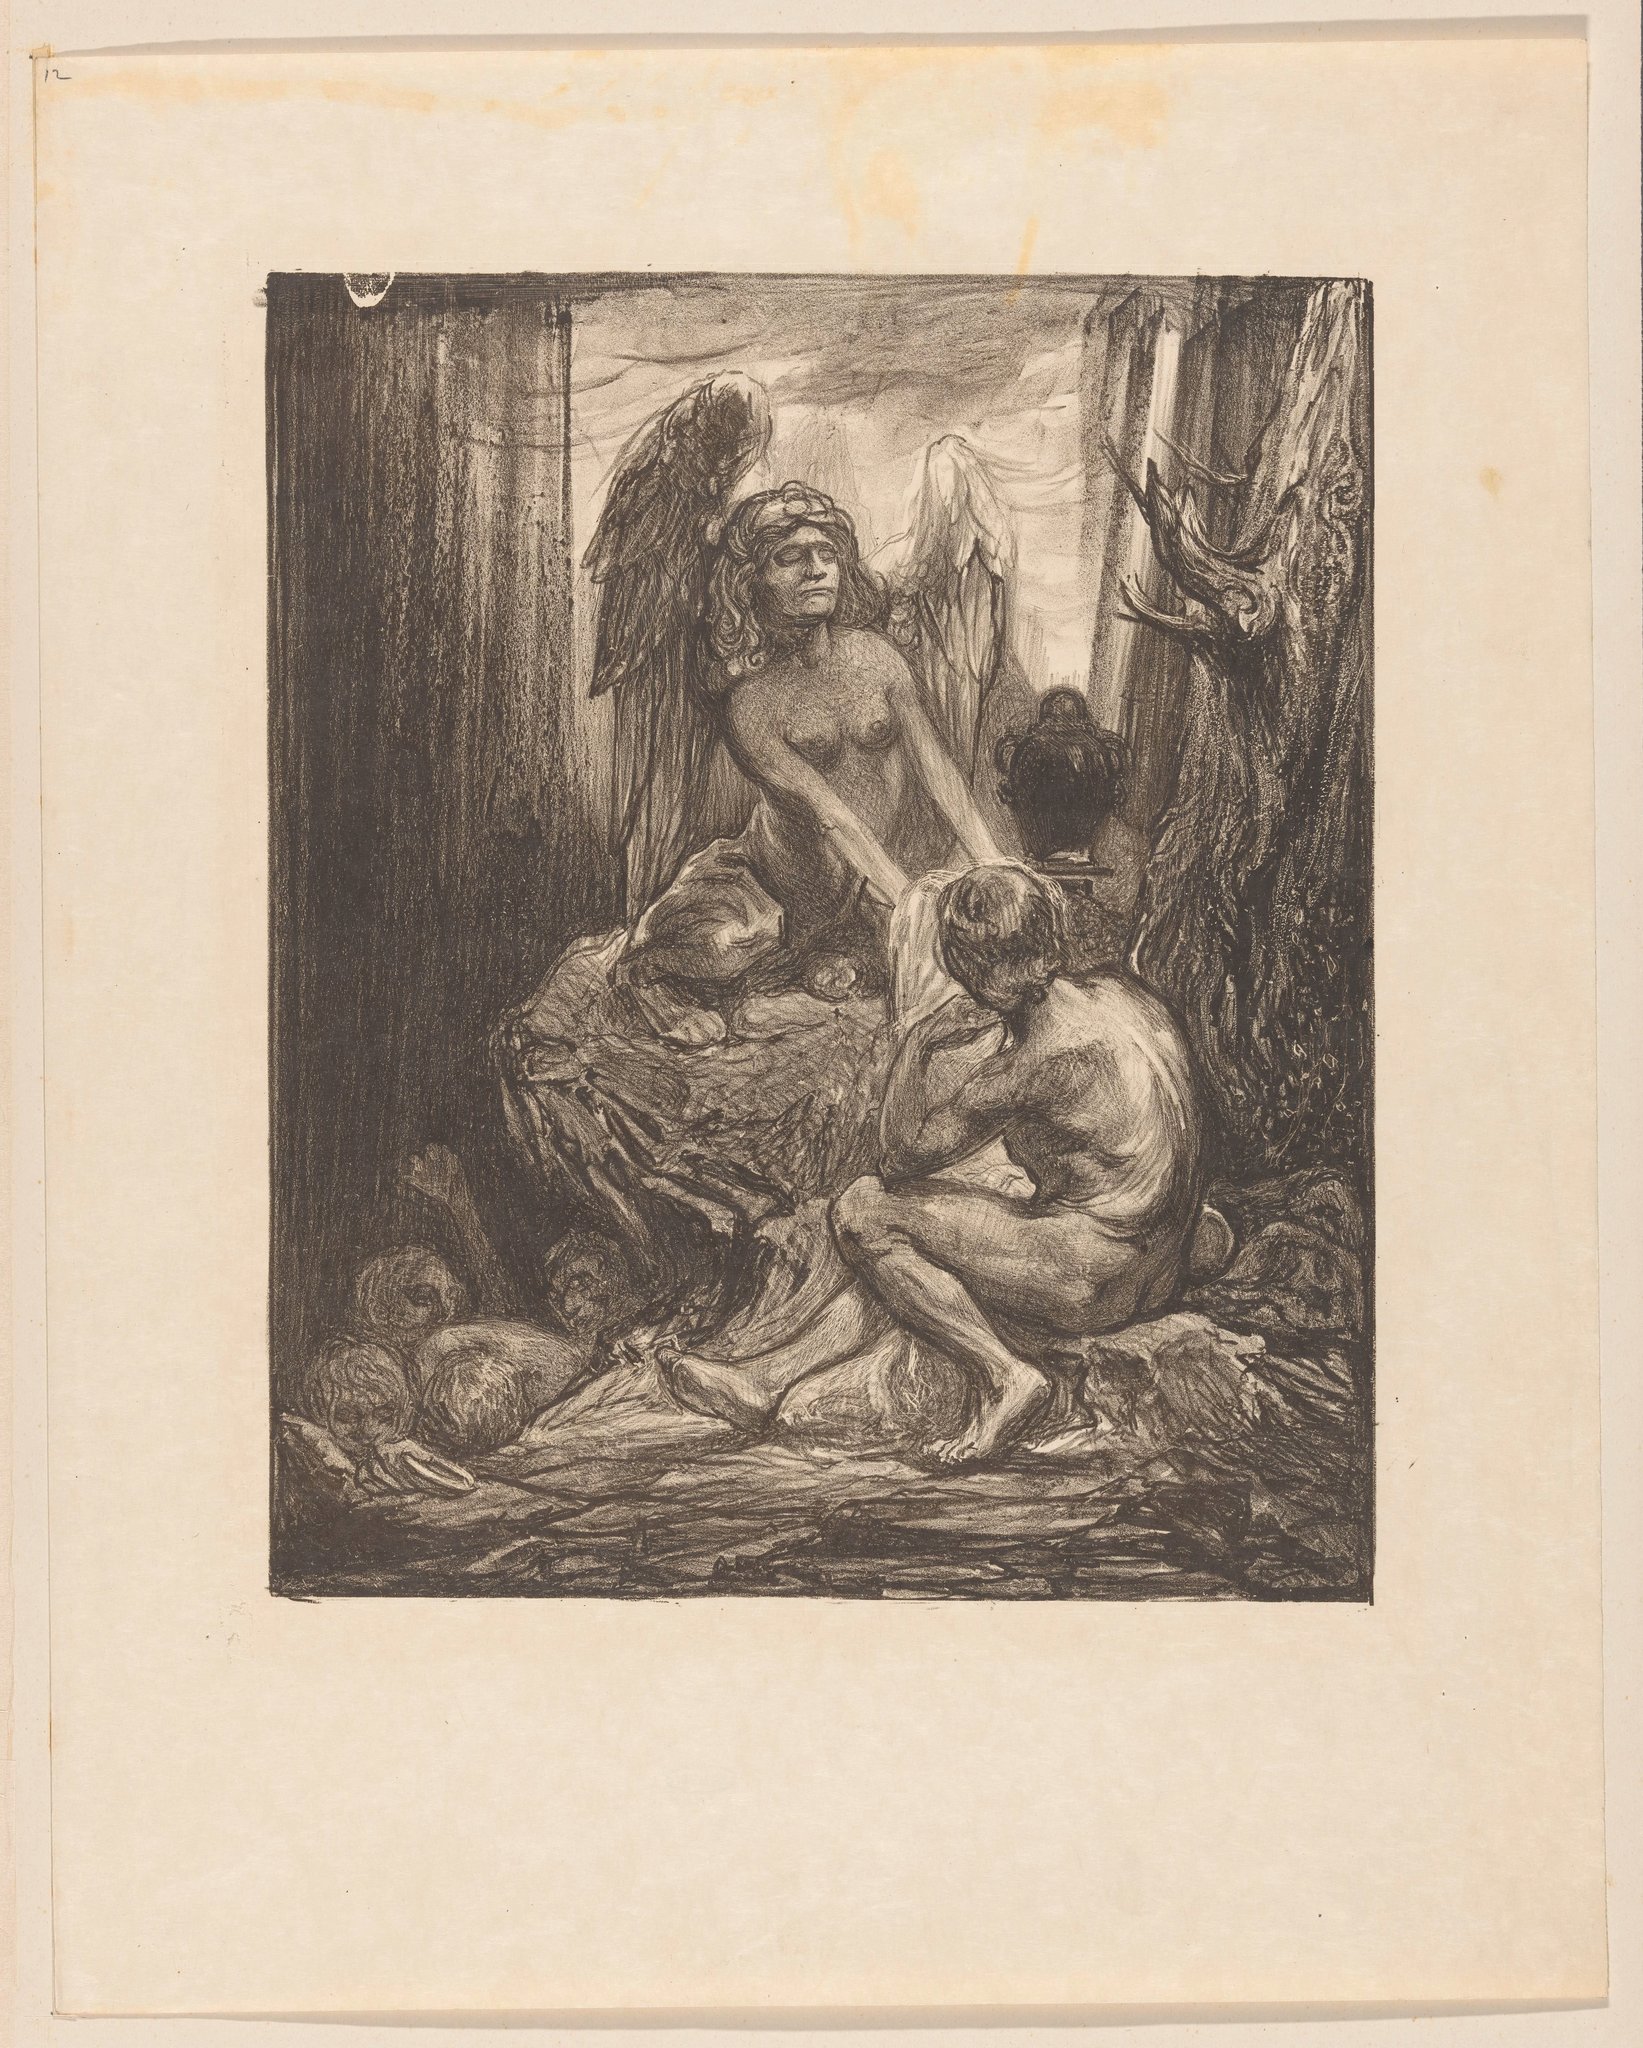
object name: print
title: Oedipus en de sfinx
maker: johannes josephus aarts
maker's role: draughtsman, print maker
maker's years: 1871-1934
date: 1881-1934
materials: paper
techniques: lithograph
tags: oedipus and the sphinx; he solves the riddle, the corpse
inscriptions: collector's mark: Lugt 2228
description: Oedipus in gezelschap van de sfinx, een monster met het hoofd van een vrouw, het lichaam van een leeuw en de vleugels van een adelaar. Hij denkt zittend na over haar raadsel: 'Welk wezen is het, dat een stem heeft en 's morgens op vier, 's middags op twee en 's avonds op drie voeten gaat?' Wie het antwoord niet wist, werd door de sfinx verscheurd. Linksonder de lichamen van eerdere slachtoffers van de sfinx.